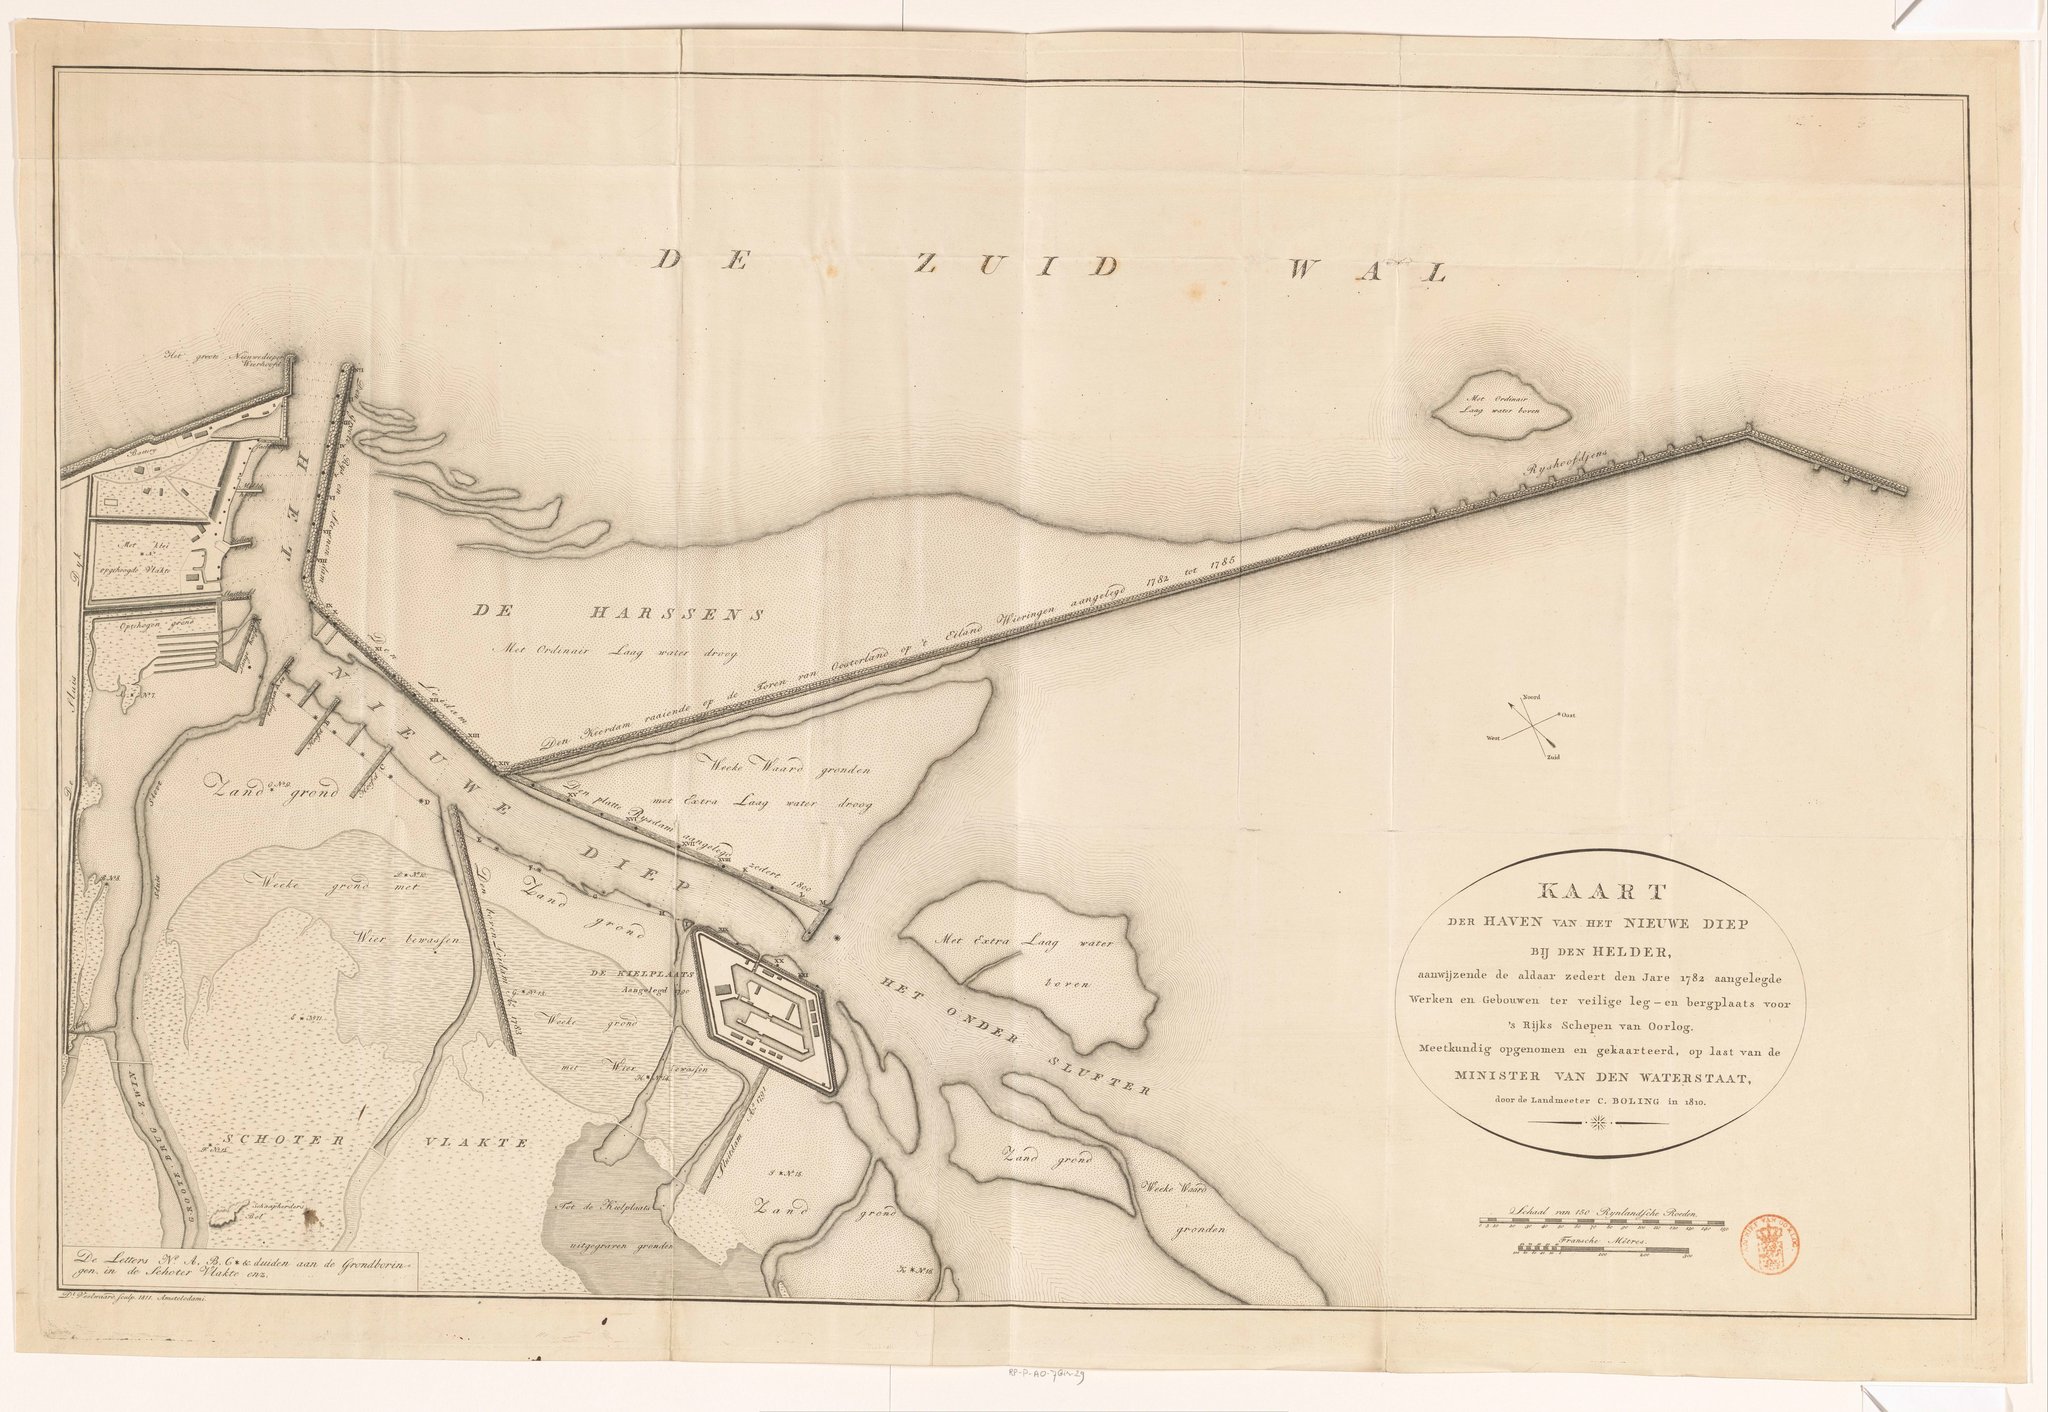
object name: print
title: Kaart van het Nieuwe Diep bij Den Helder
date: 1811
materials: paper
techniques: engraving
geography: amsterdam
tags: harbour, maps of separate countries or regions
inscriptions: collector's mark: Lugt 19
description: Kaart van het Nieuwe Diep bij Den Helder, met daarop de lig- en bergplaatsen van de oorlogsschepen van de Nederlandse vloot. Rechtsonder de titelcartouche met daaronder twee schaalstokken: Schaal van 150 Rynlandsche roeden; Fransche mêtres.